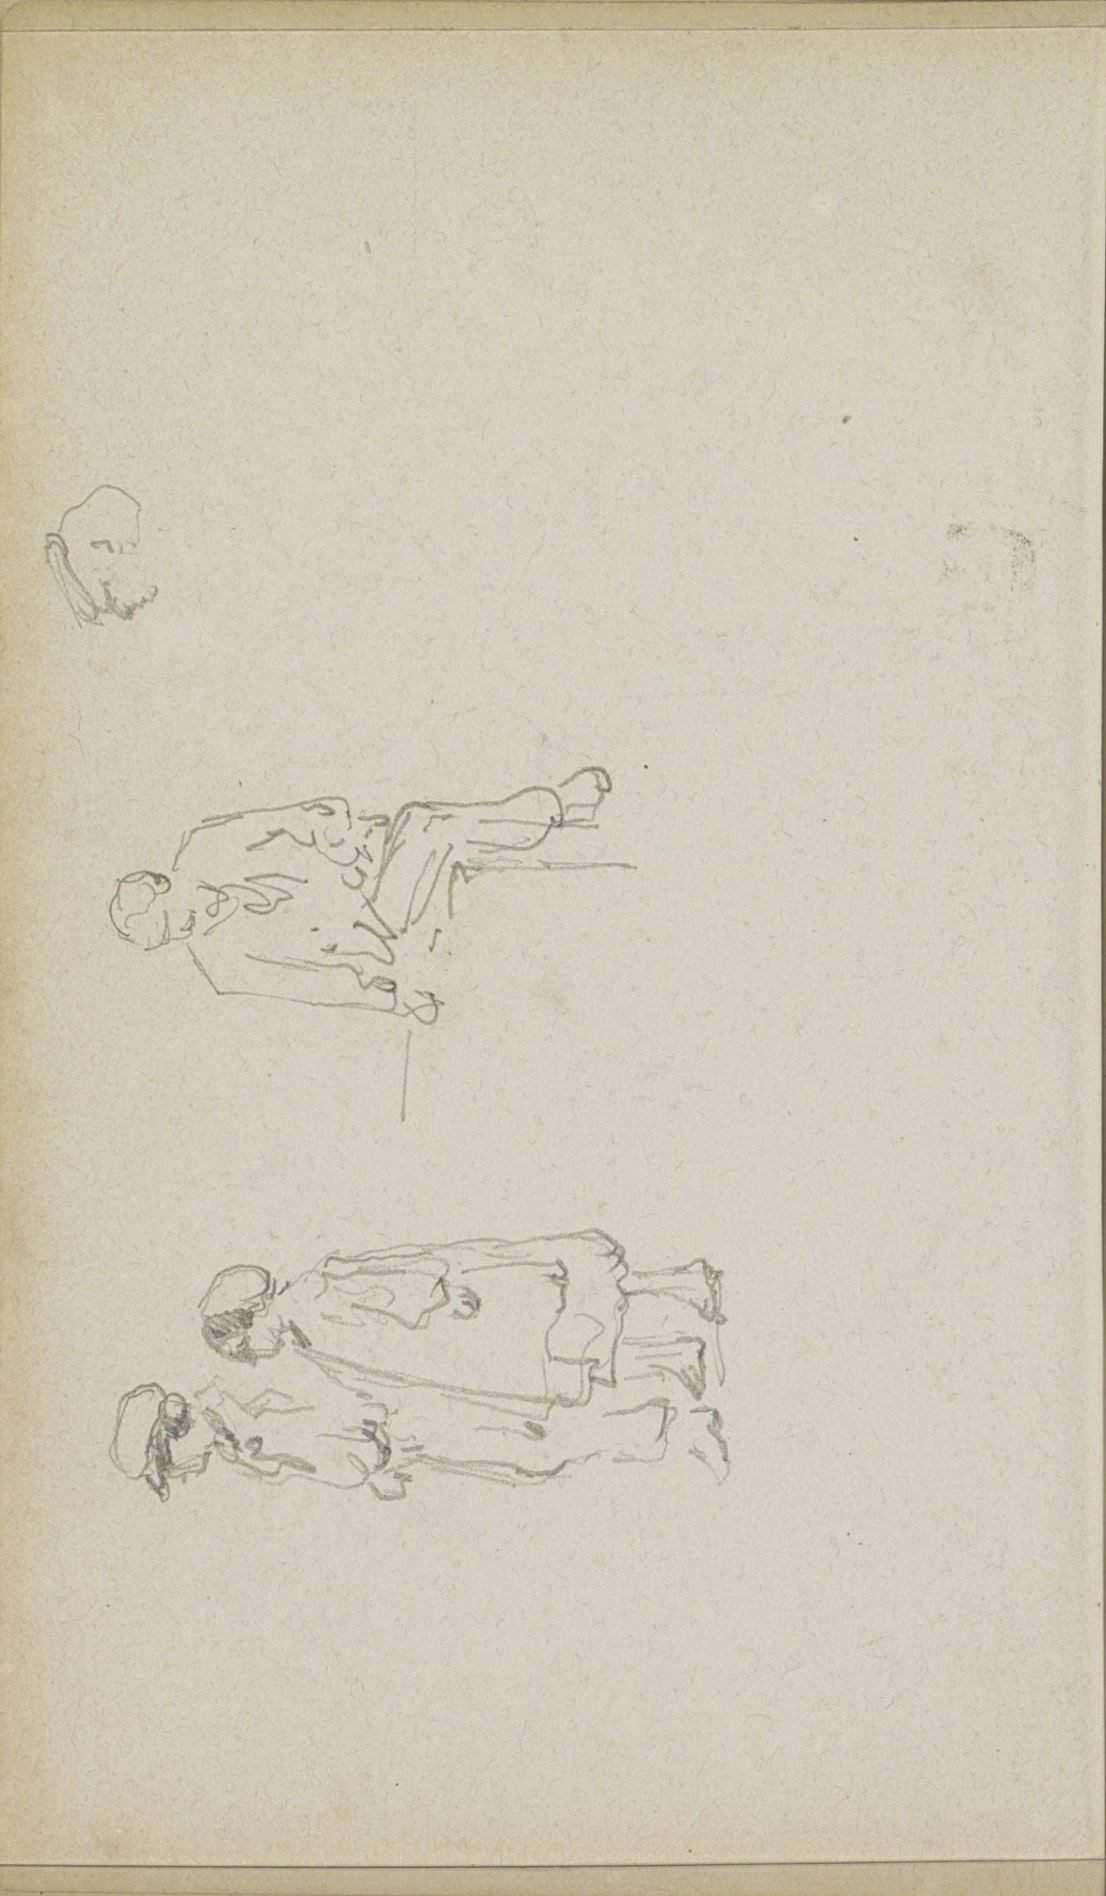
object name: sketchbook leaf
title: Figuurstudies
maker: adrianus eversen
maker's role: draughtsman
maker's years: 1818-1897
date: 1828-1897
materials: paper, pencil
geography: netherlands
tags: sitting figure, head (human) (+ sideview, profile)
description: Links een jonge man met een meisje in profiel. In het midden een zittende man en rechts een hoofd naar links. Blad 15 verso uit een schetsboek met 69 bladen vervaardigd in de omgeving van Delft, Rotterdam, Oudewater en Harlingen.